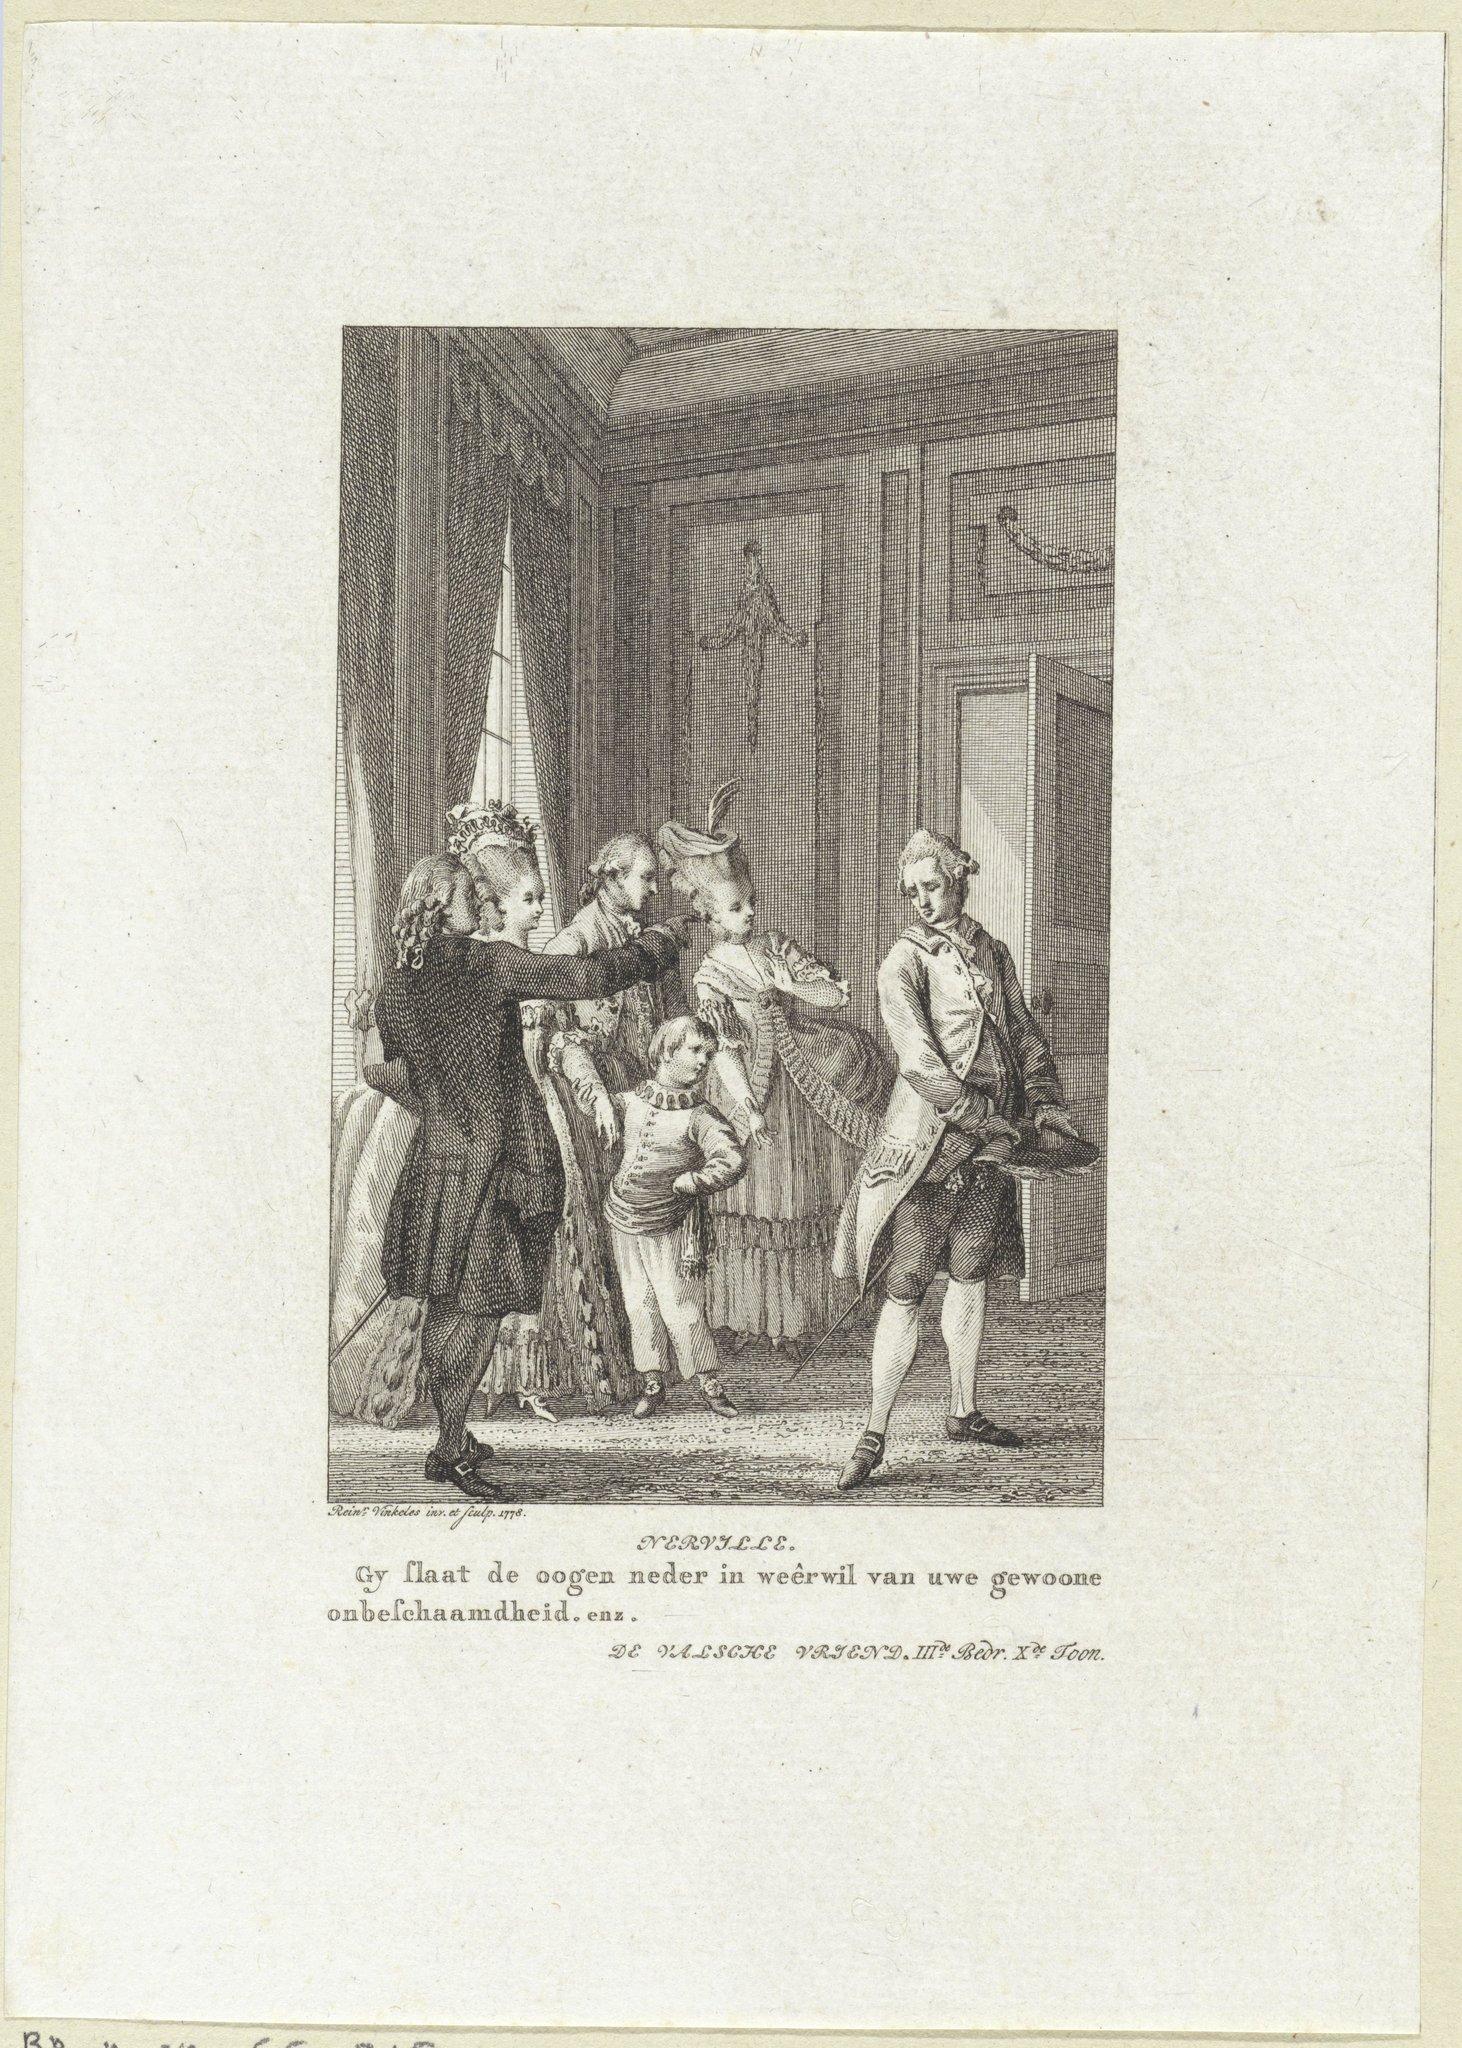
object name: print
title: In een gezelschap wordt een man de deur gewezen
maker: reinier vinkeles (i)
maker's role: draughtsman, print maker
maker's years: 1741-1816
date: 1778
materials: paper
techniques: engraving, etching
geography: amsterdam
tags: door, index finger forwards, pointing, indicating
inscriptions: collector's mark: Lugt 240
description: Illustratie die mogelijk is gebruikt in: Mercier, Louis-Sébastien. De valsche vriend. Amsterdam: Albert van der Kroe, 1778.